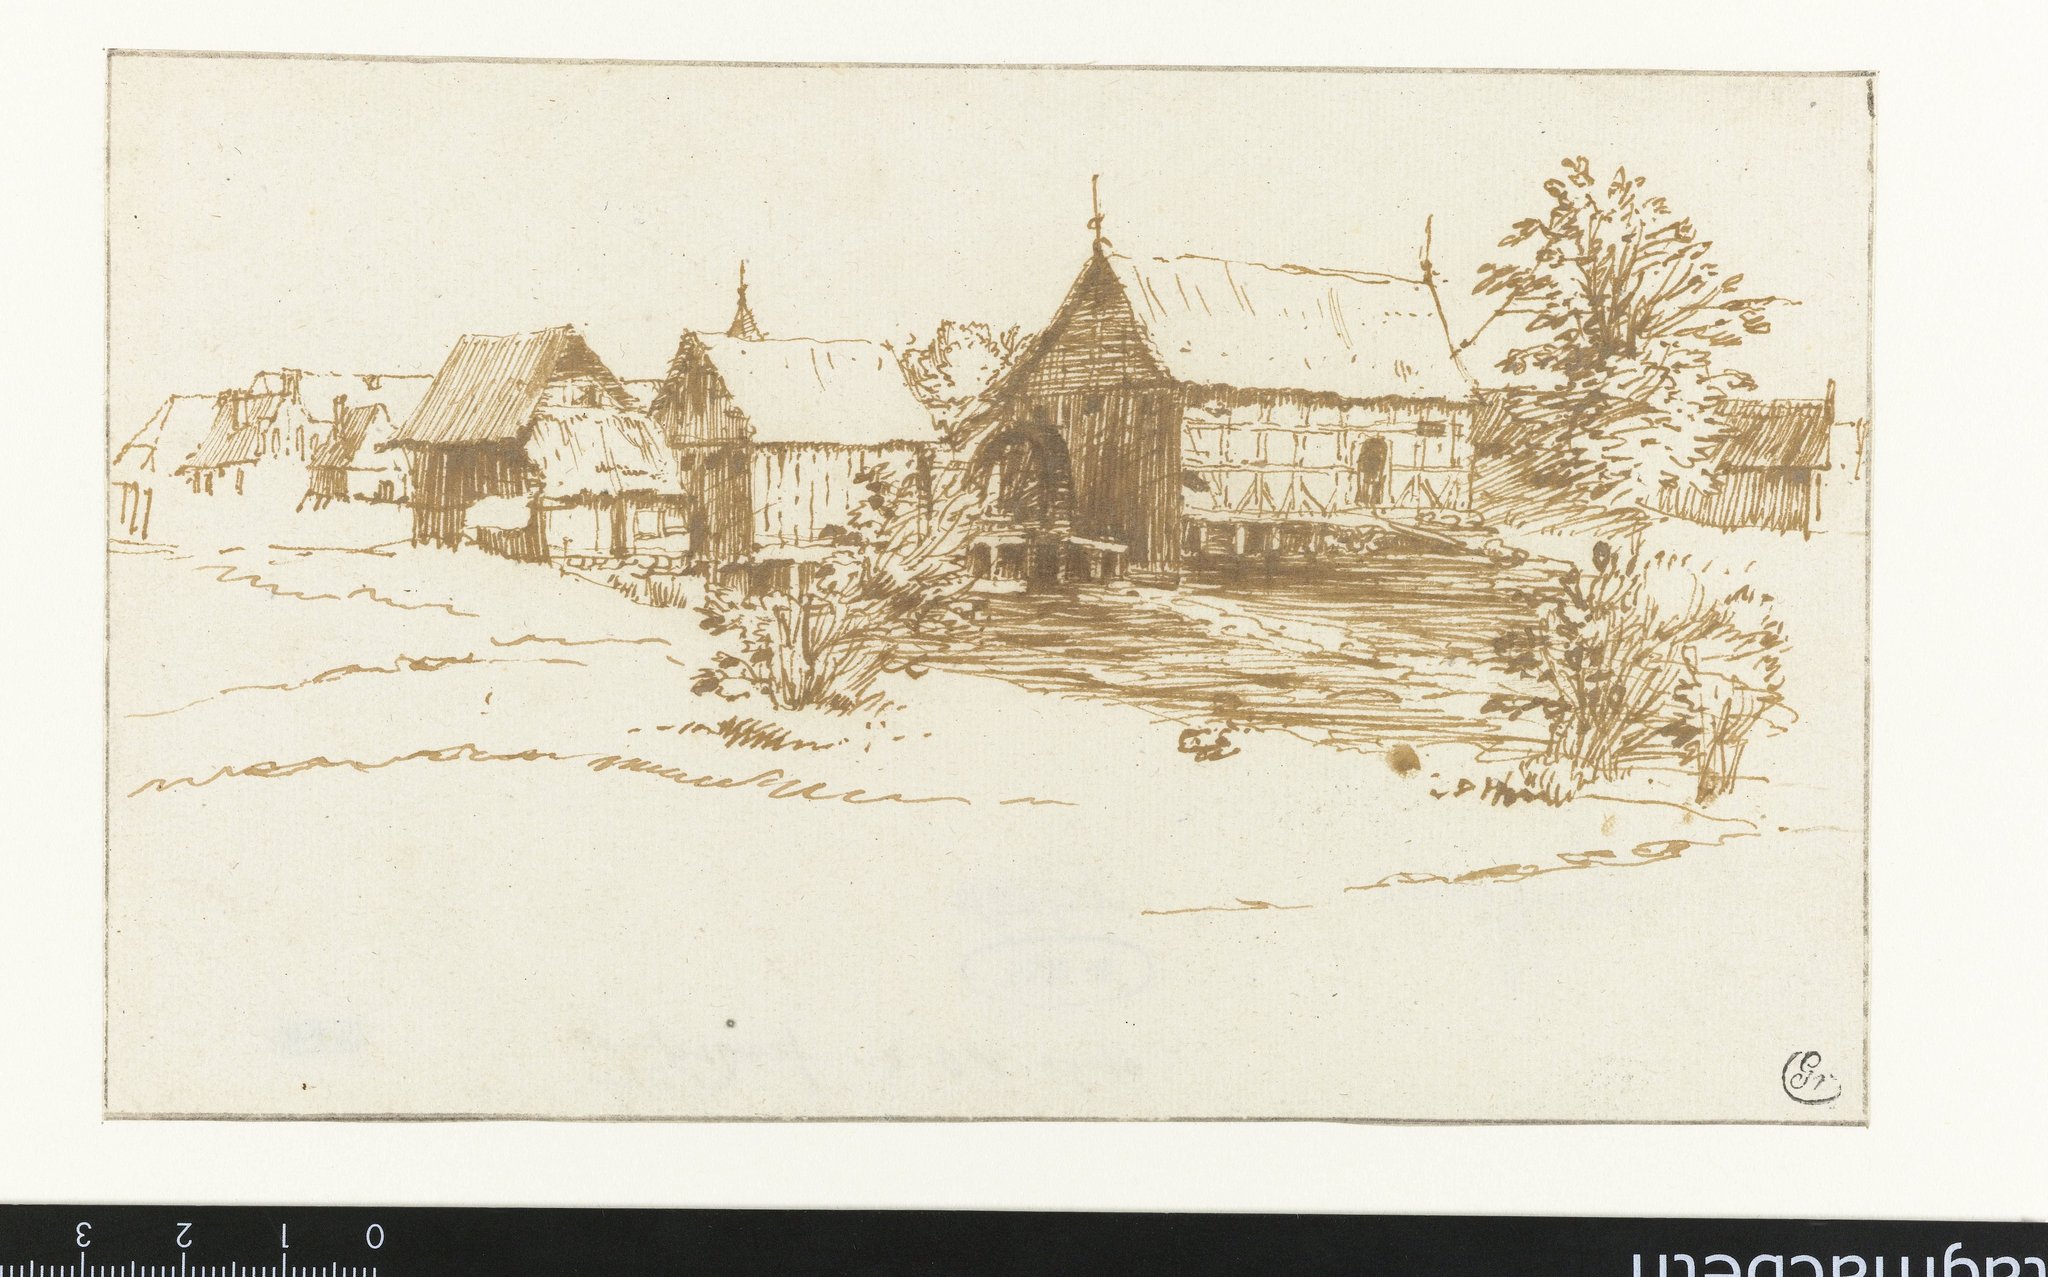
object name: drawing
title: Ebstorf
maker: constantijn huygens (ii)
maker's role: draughtsman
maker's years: 1628-1697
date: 1680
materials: ink, paper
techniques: pen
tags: prospect of village, silhouette of village, watermill in landscape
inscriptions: date: ‘4.Oct.1680’